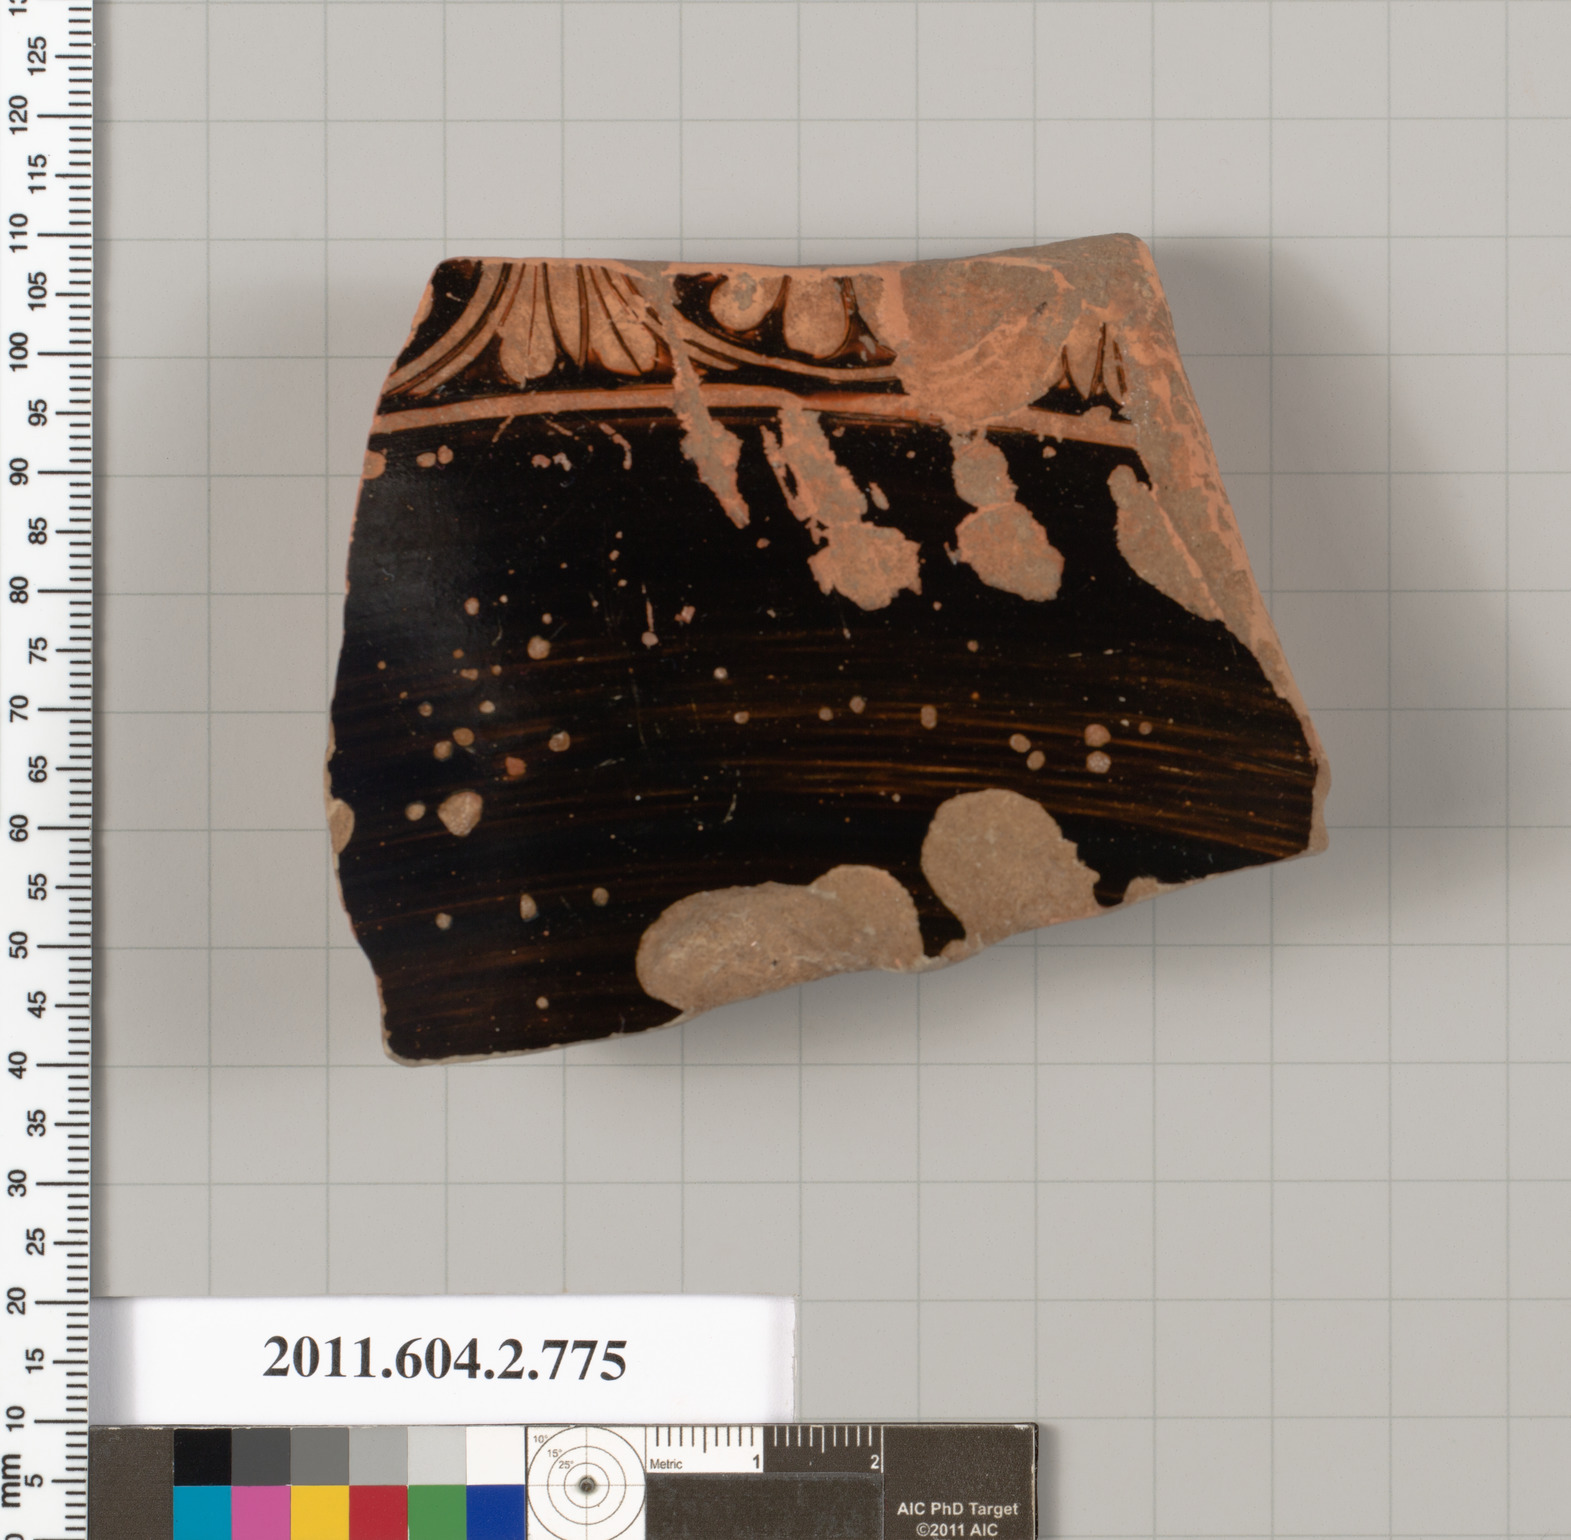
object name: calyx krater fragment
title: Terracotta fragment of a calyx-krater (bowl for mixing wine and water)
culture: greek, attic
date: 500-476 BCE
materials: terracotta